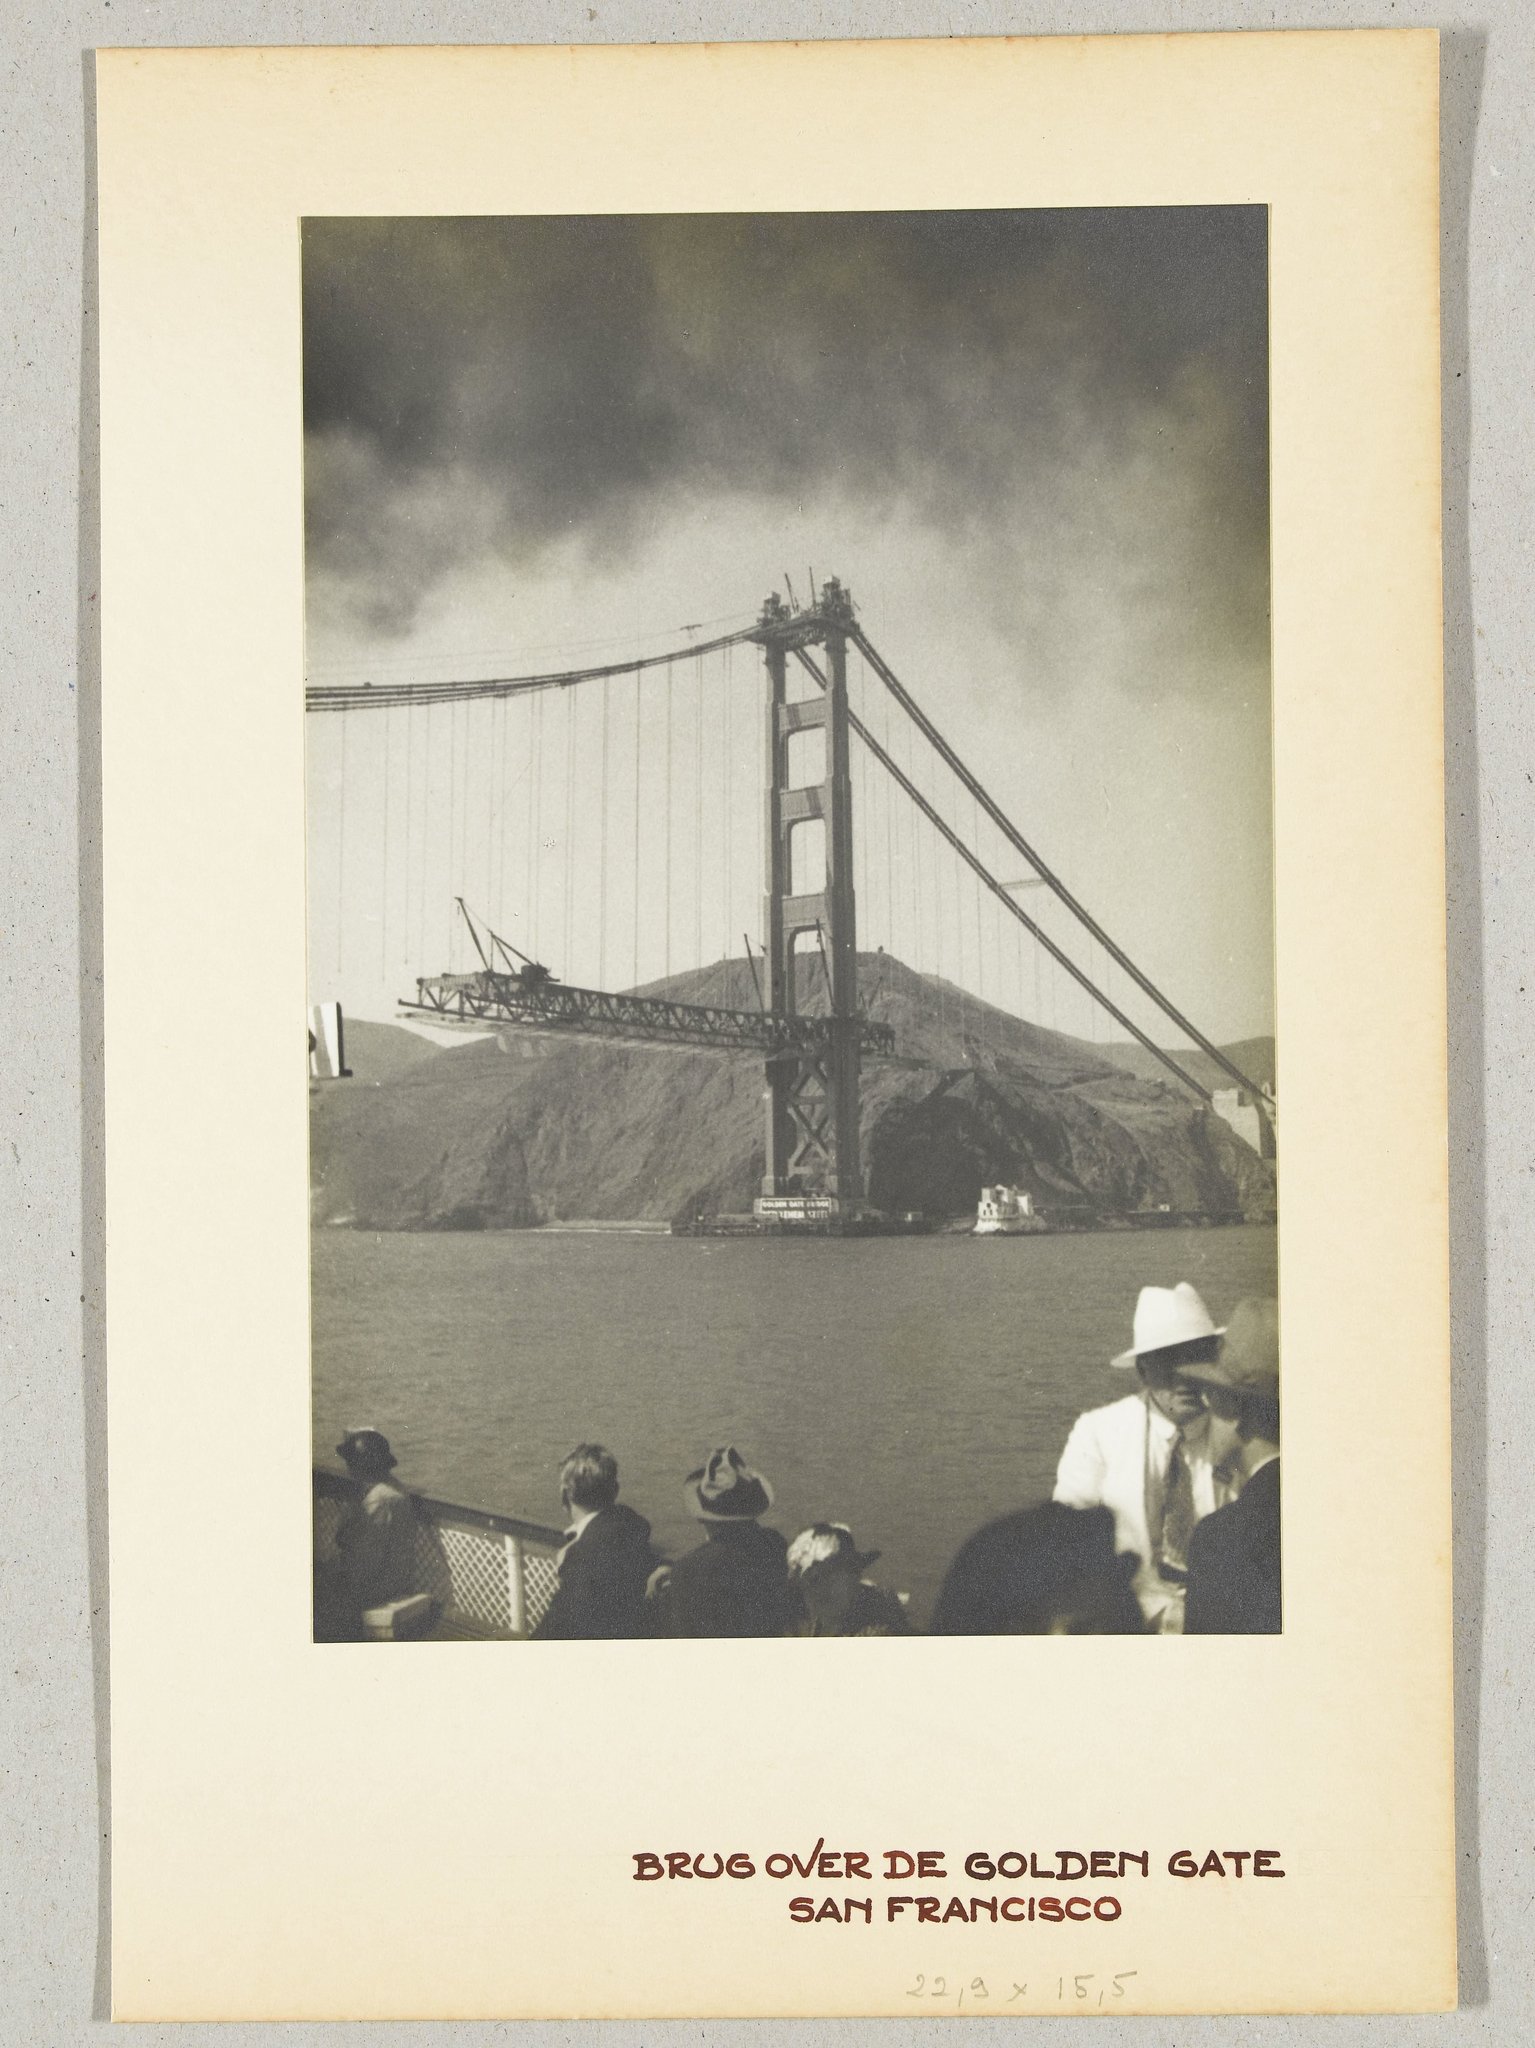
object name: photograph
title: Golden Gate Bridge, San Francisco, Verenigde Staten, in aanbouw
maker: wouter cool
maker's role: engineer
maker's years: 1877-1947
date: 1936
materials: cardboard, paper, photographic support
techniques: gelatin silver print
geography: united states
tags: bridge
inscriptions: title: ‘BRUG OVER DE GOLDEN GATE / SAN FRANCISCO’